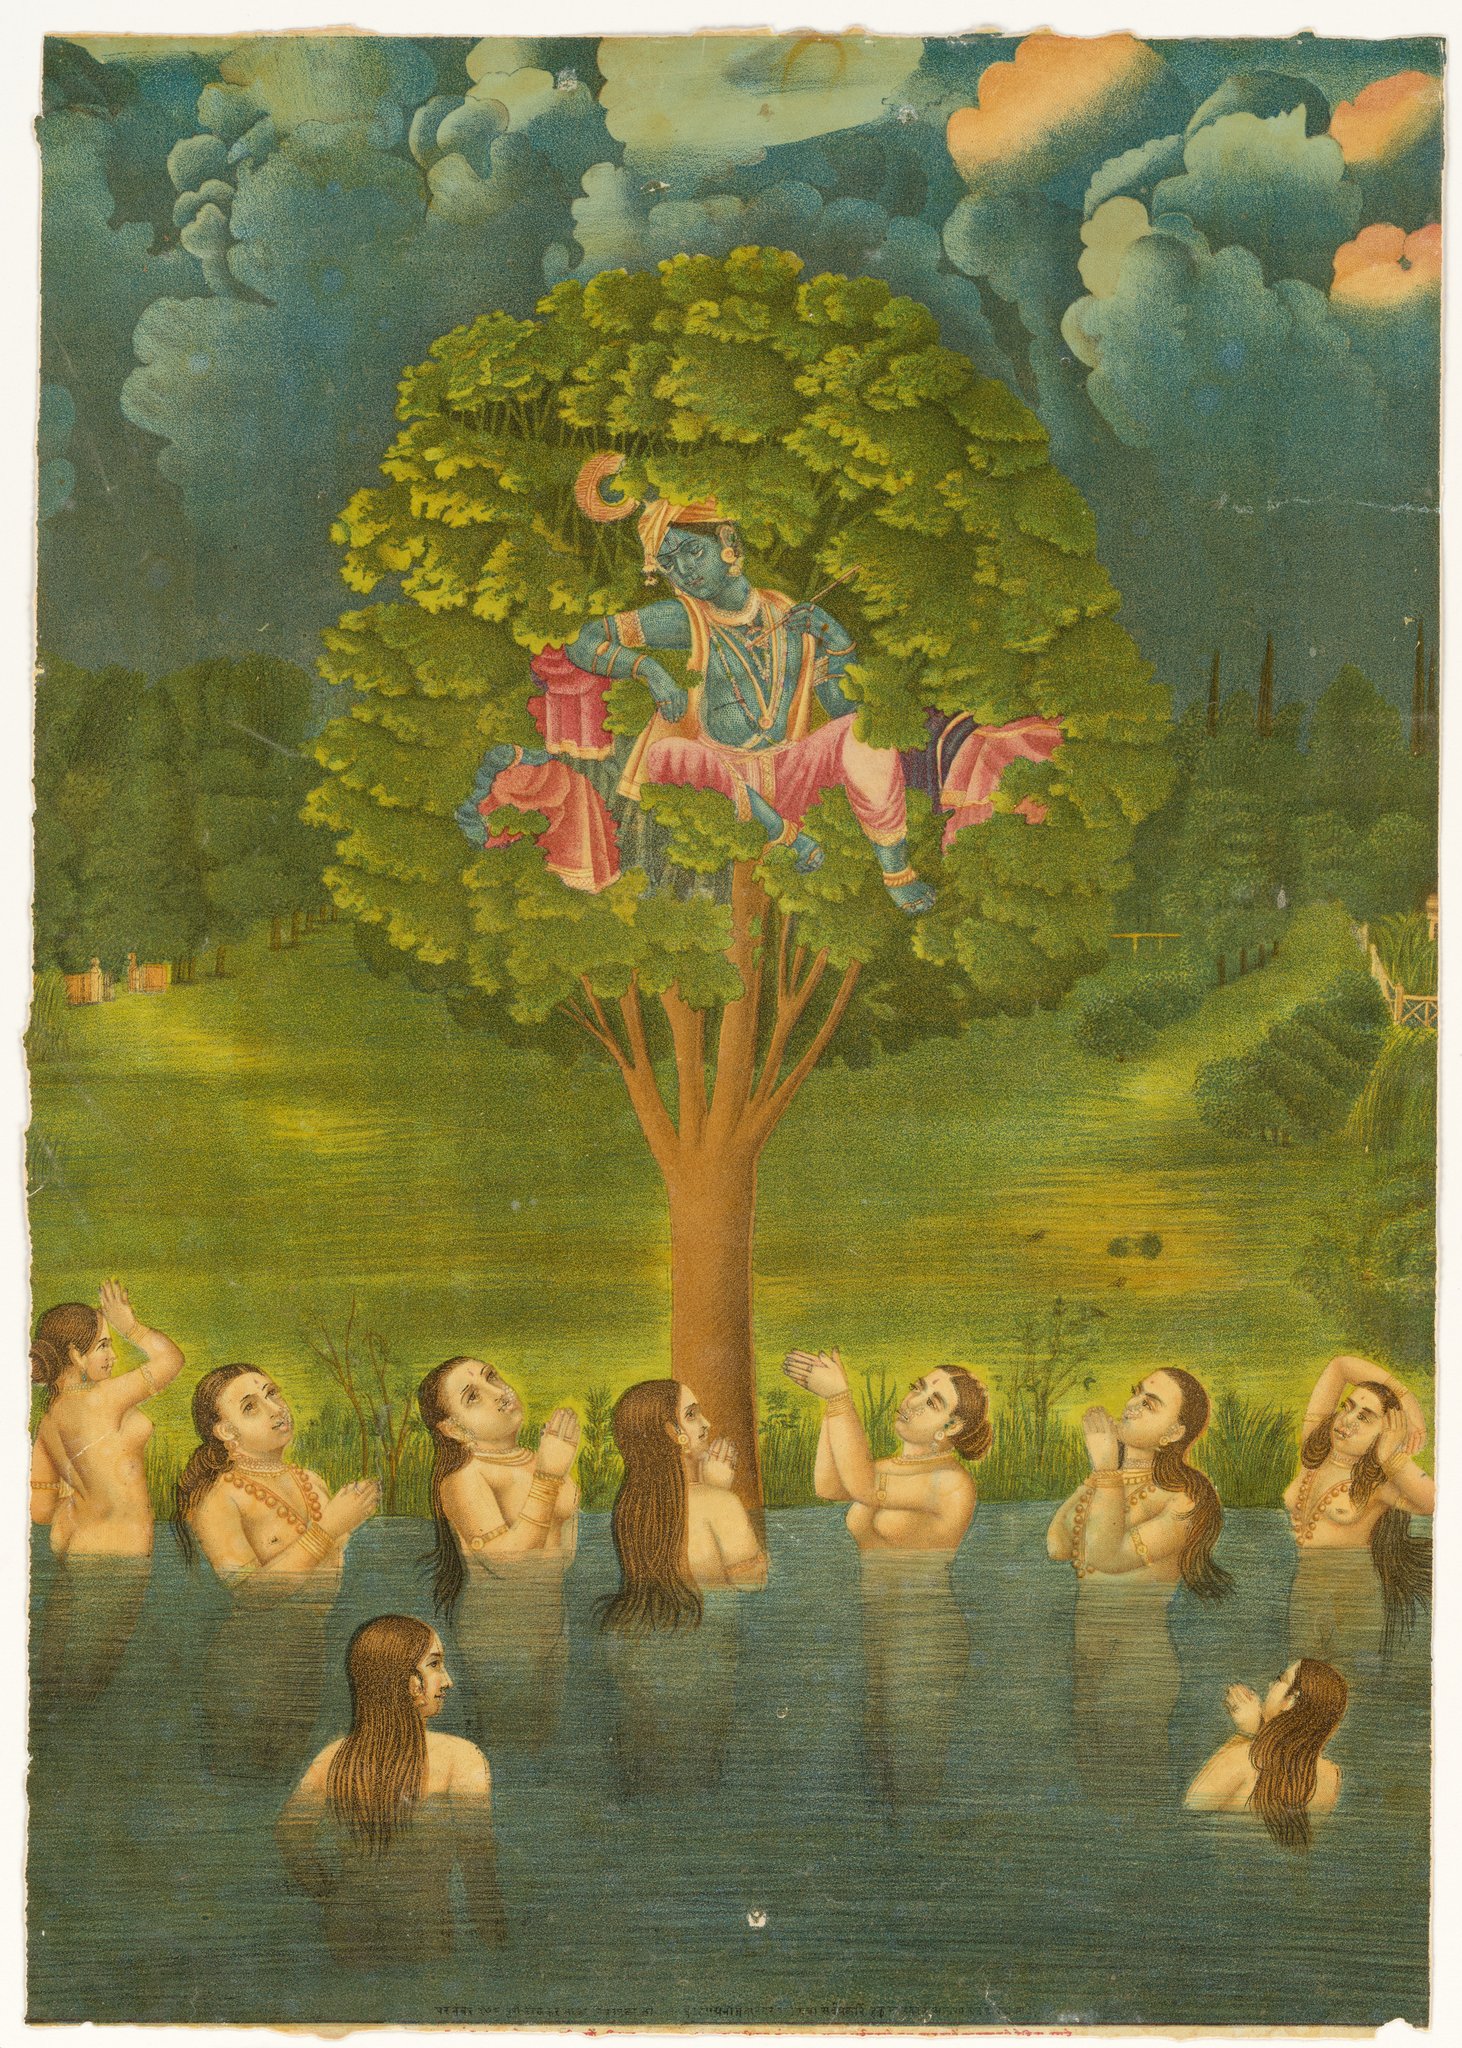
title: Krishna Steals the Clothes of the Gopis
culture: indian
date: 1875-1880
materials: varnish